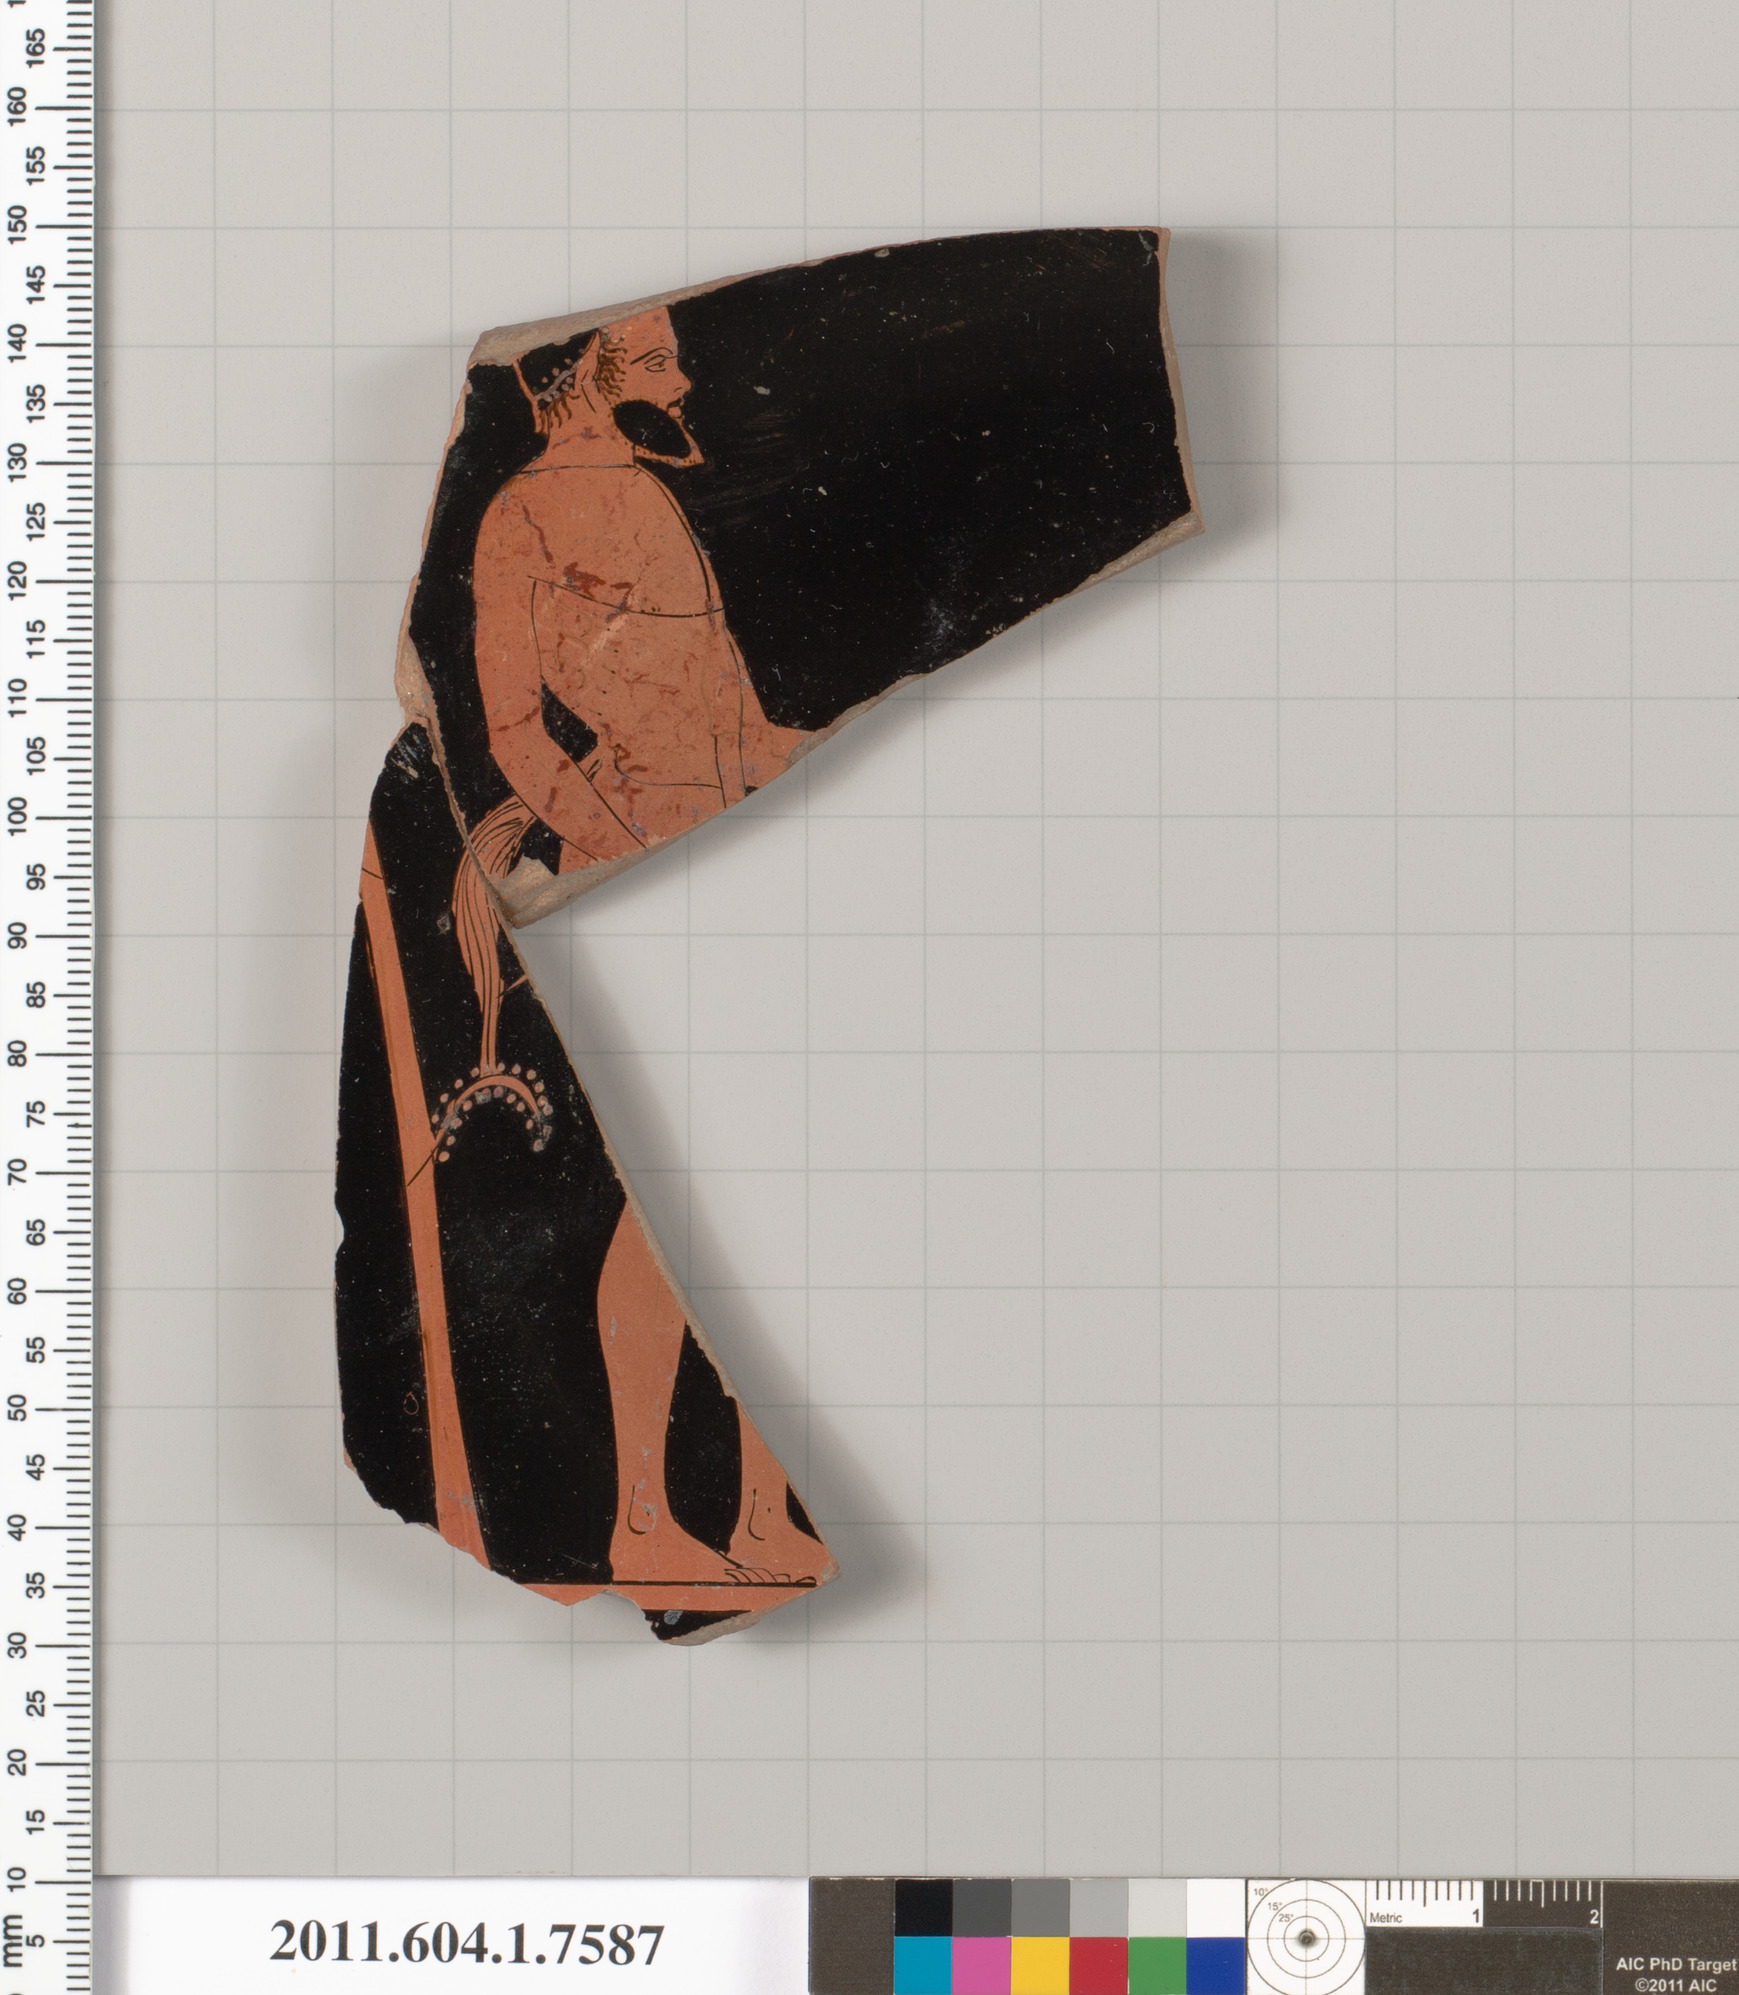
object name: kylix fragment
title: Terracotta fragment of a kylix (drinking cup)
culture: greek, attic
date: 460-450 BCE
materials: terracotta